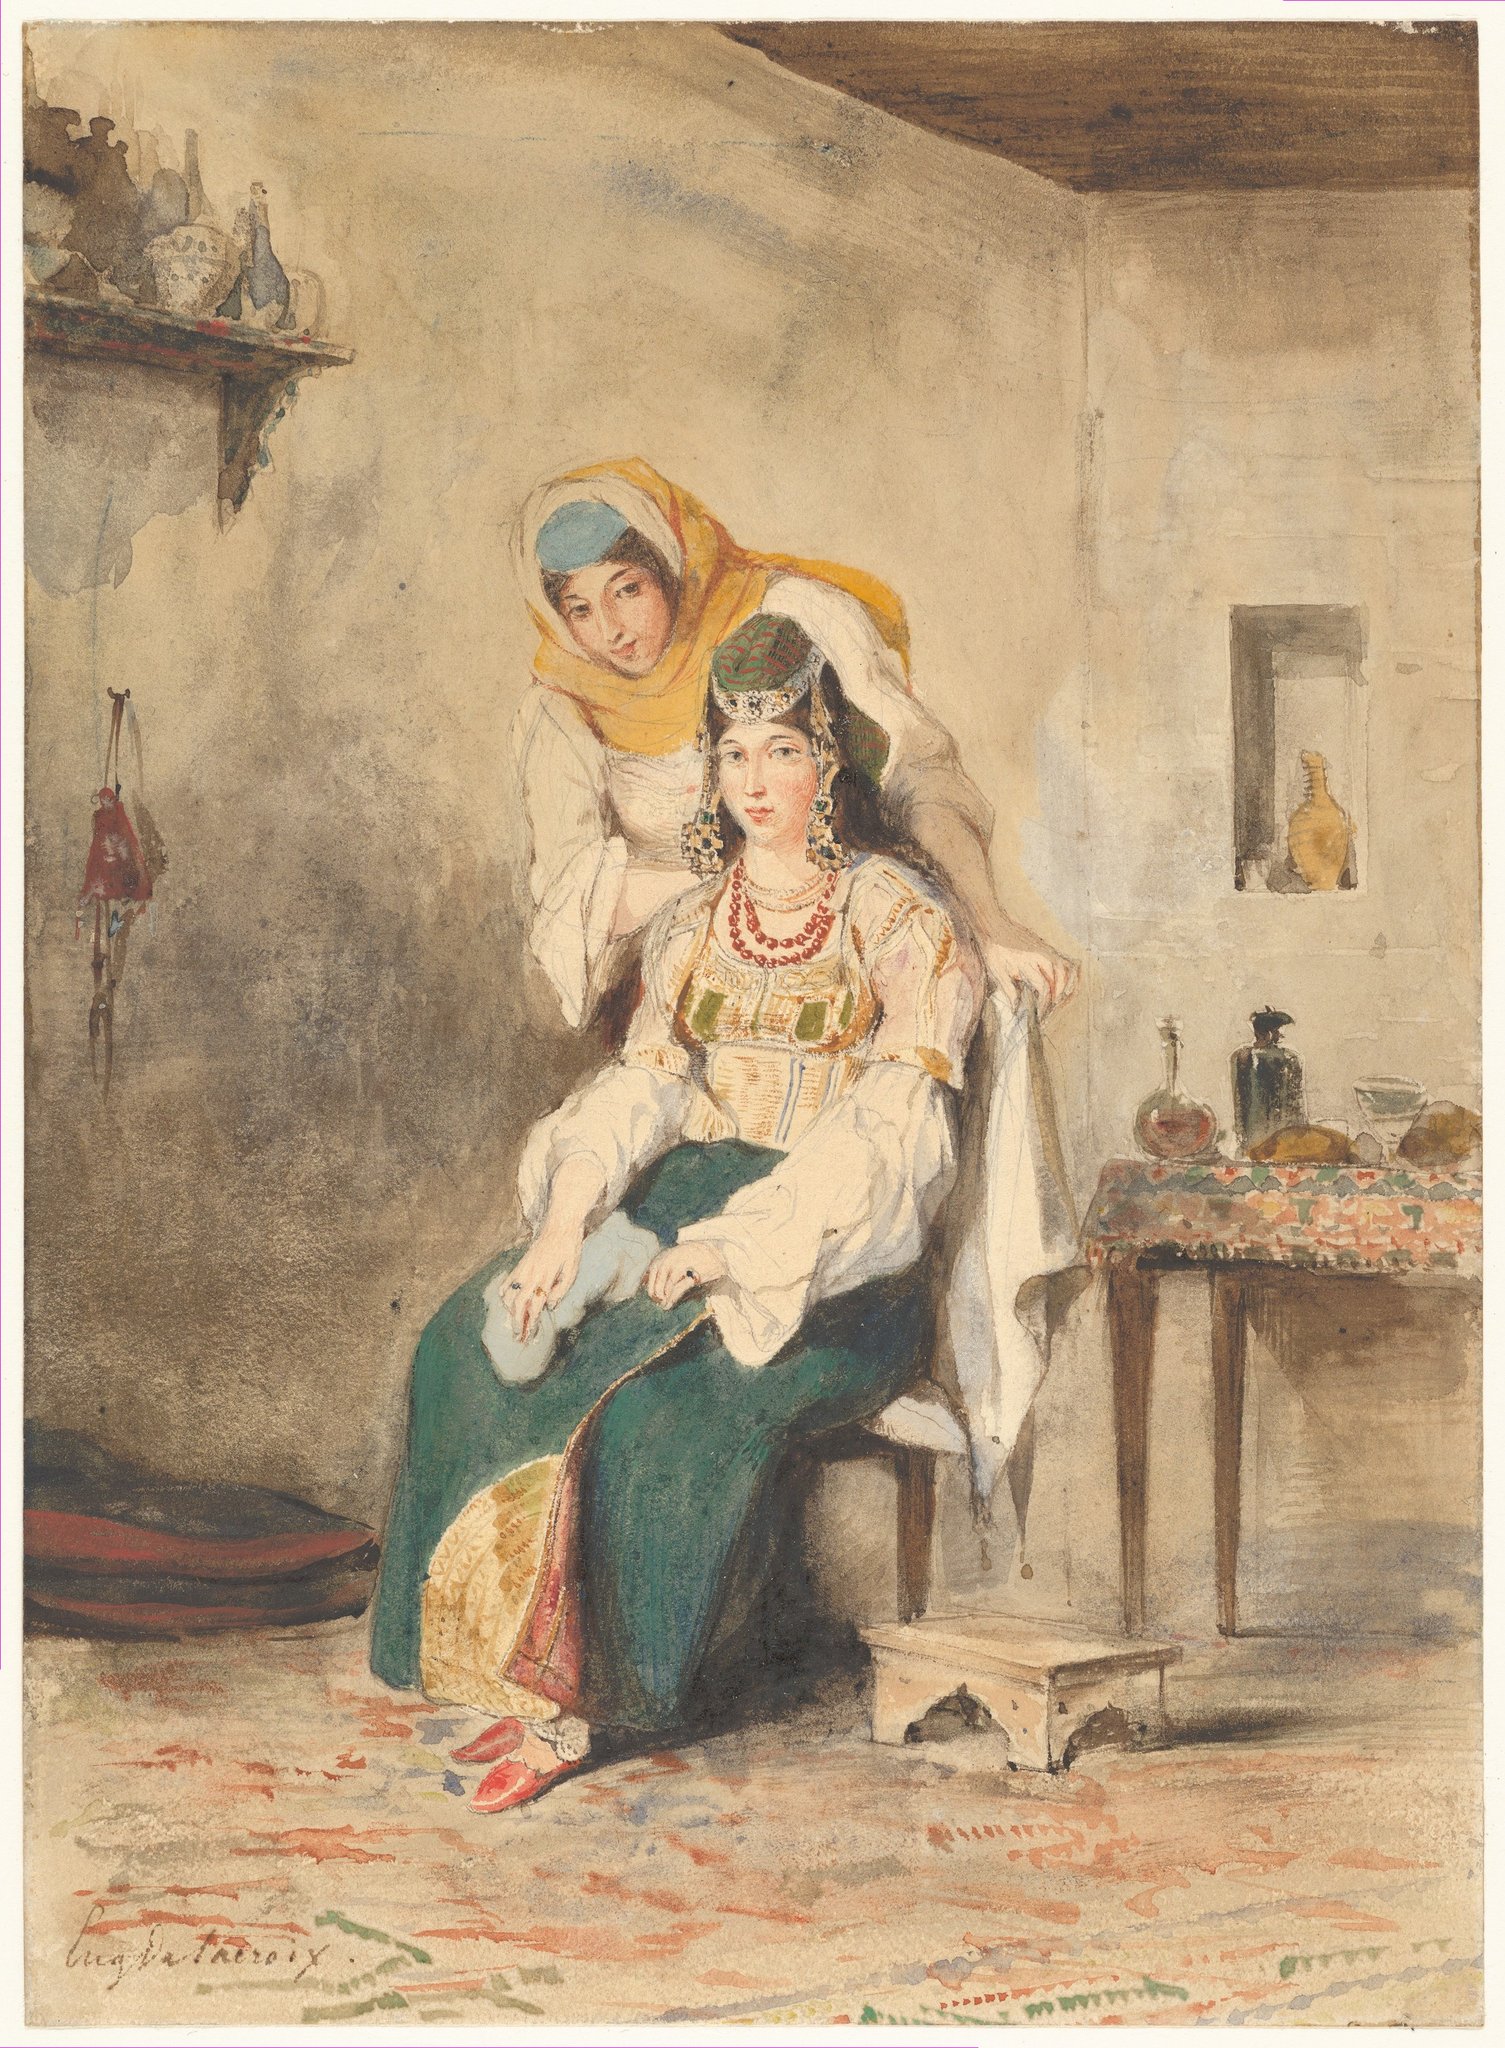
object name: drawing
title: Saada, the Wife of Abraham Ben-Chimol, and Préciada, One of Their Daughters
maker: eugène delacroix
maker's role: artist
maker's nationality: french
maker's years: 1798-1863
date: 1832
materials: graphite, watercolor, paper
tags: women